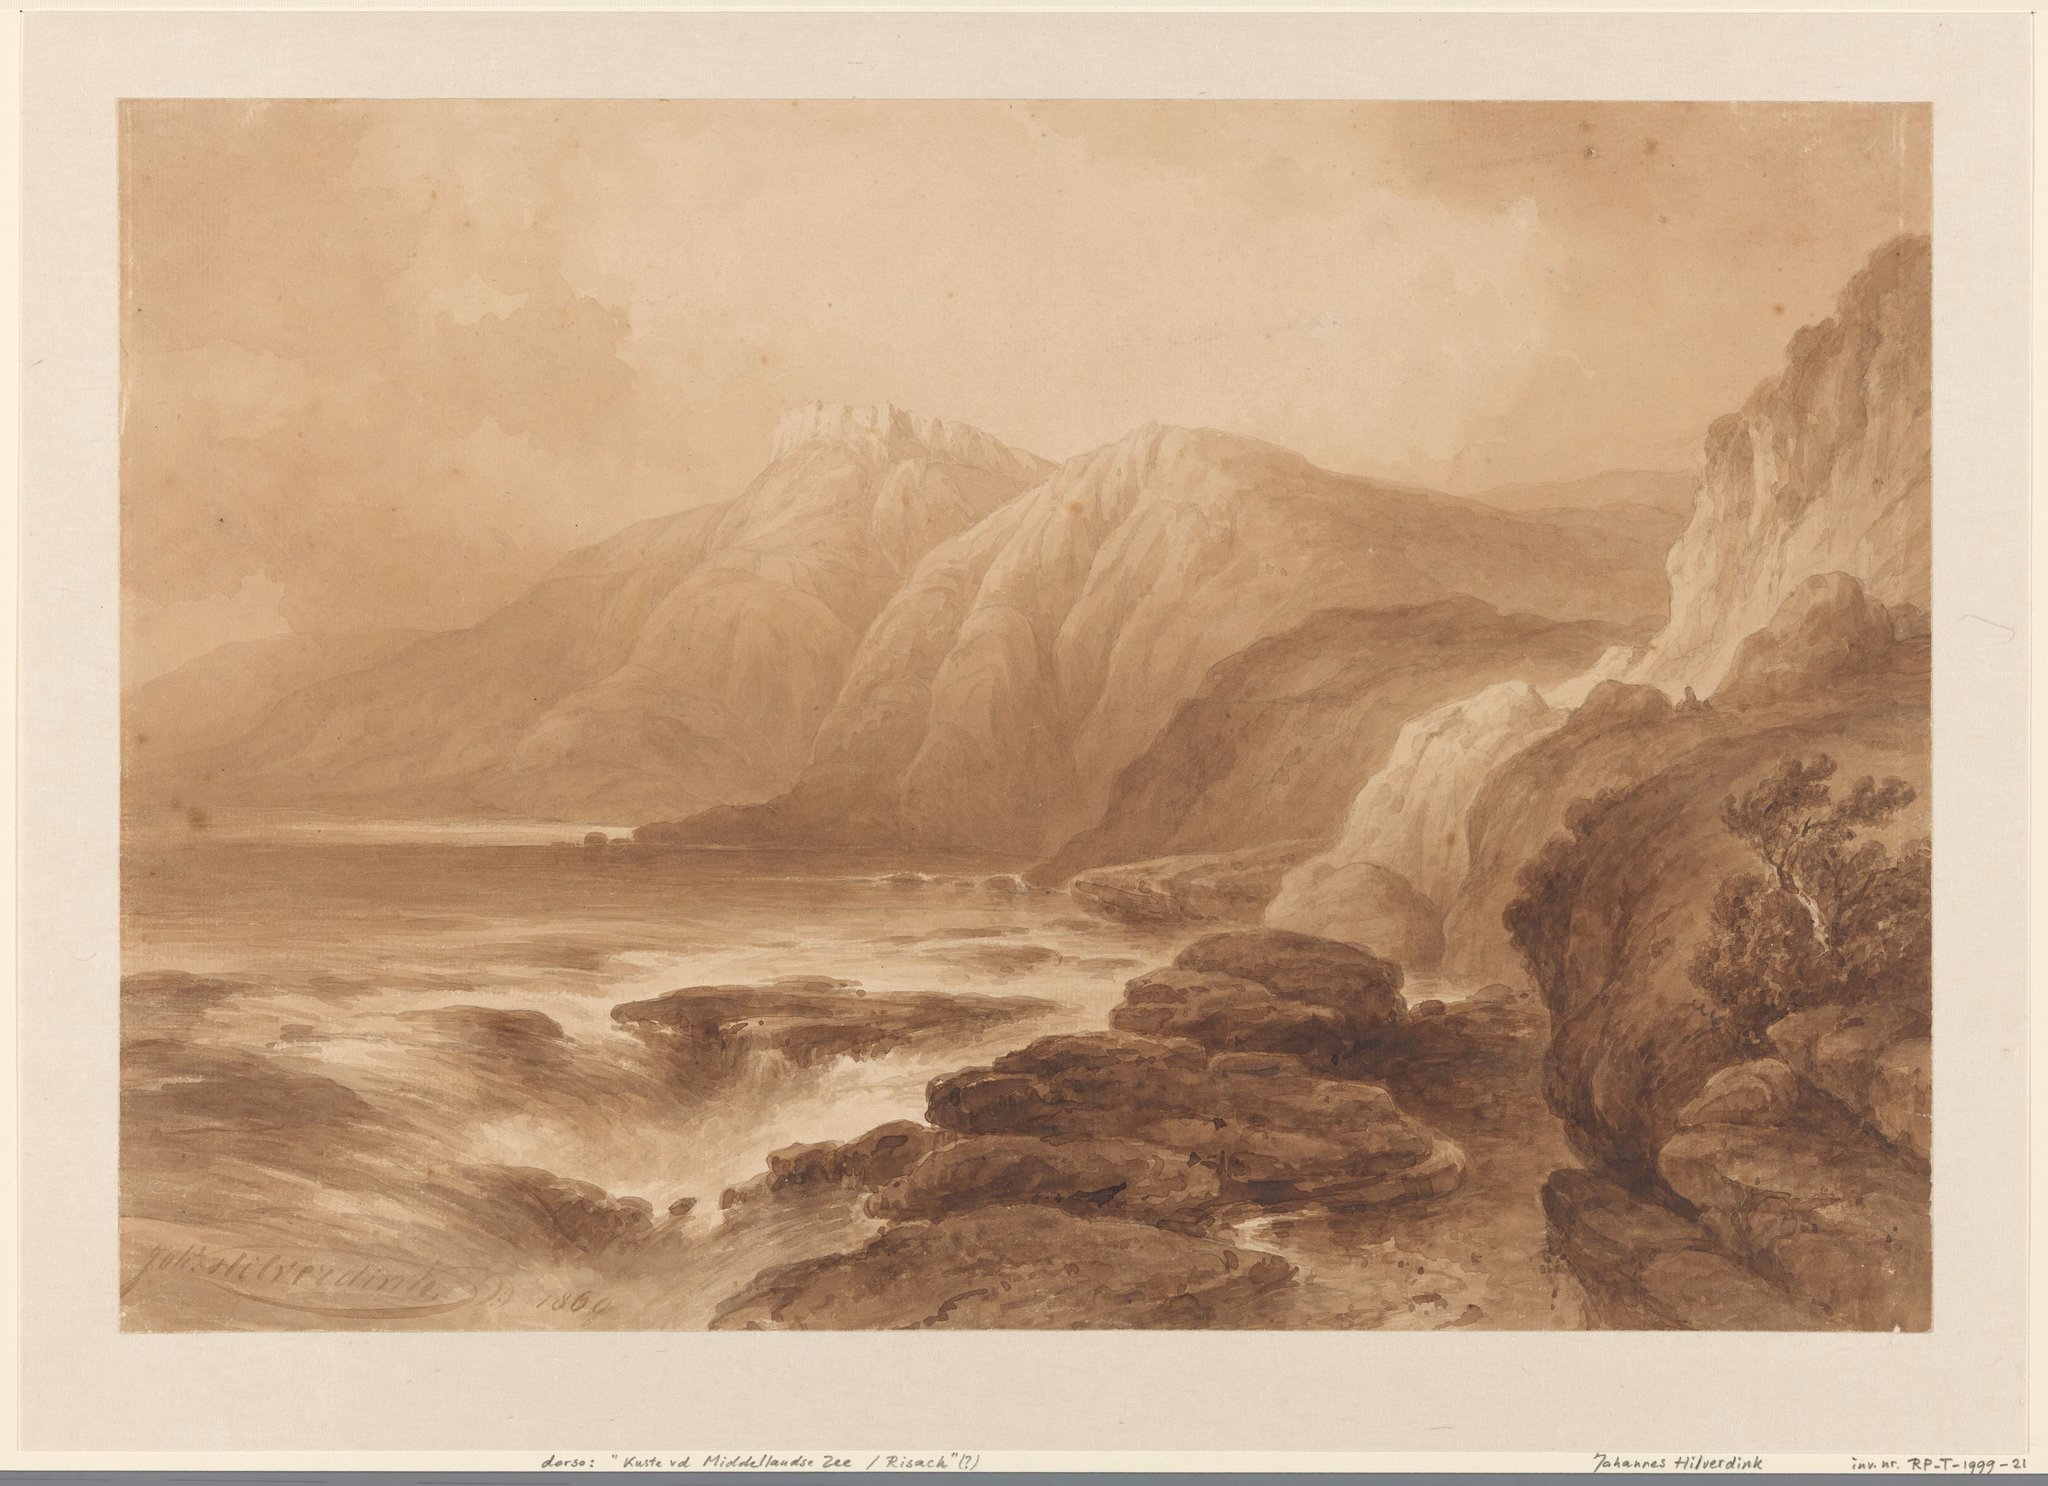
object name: drawing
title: Gezicht op een hoge rotskust, met op een der bergtoppen een vesting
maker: johannes hilverdink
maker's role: draughtsman, painter, print maker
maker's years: 1813-1902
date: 1860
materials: paper, pencil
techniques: brush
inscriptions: inscription: ‘Kuste vd Middellandse Zee/Risach (?)’, signature and date: ‘Joh.s Hilverdink: 1860’